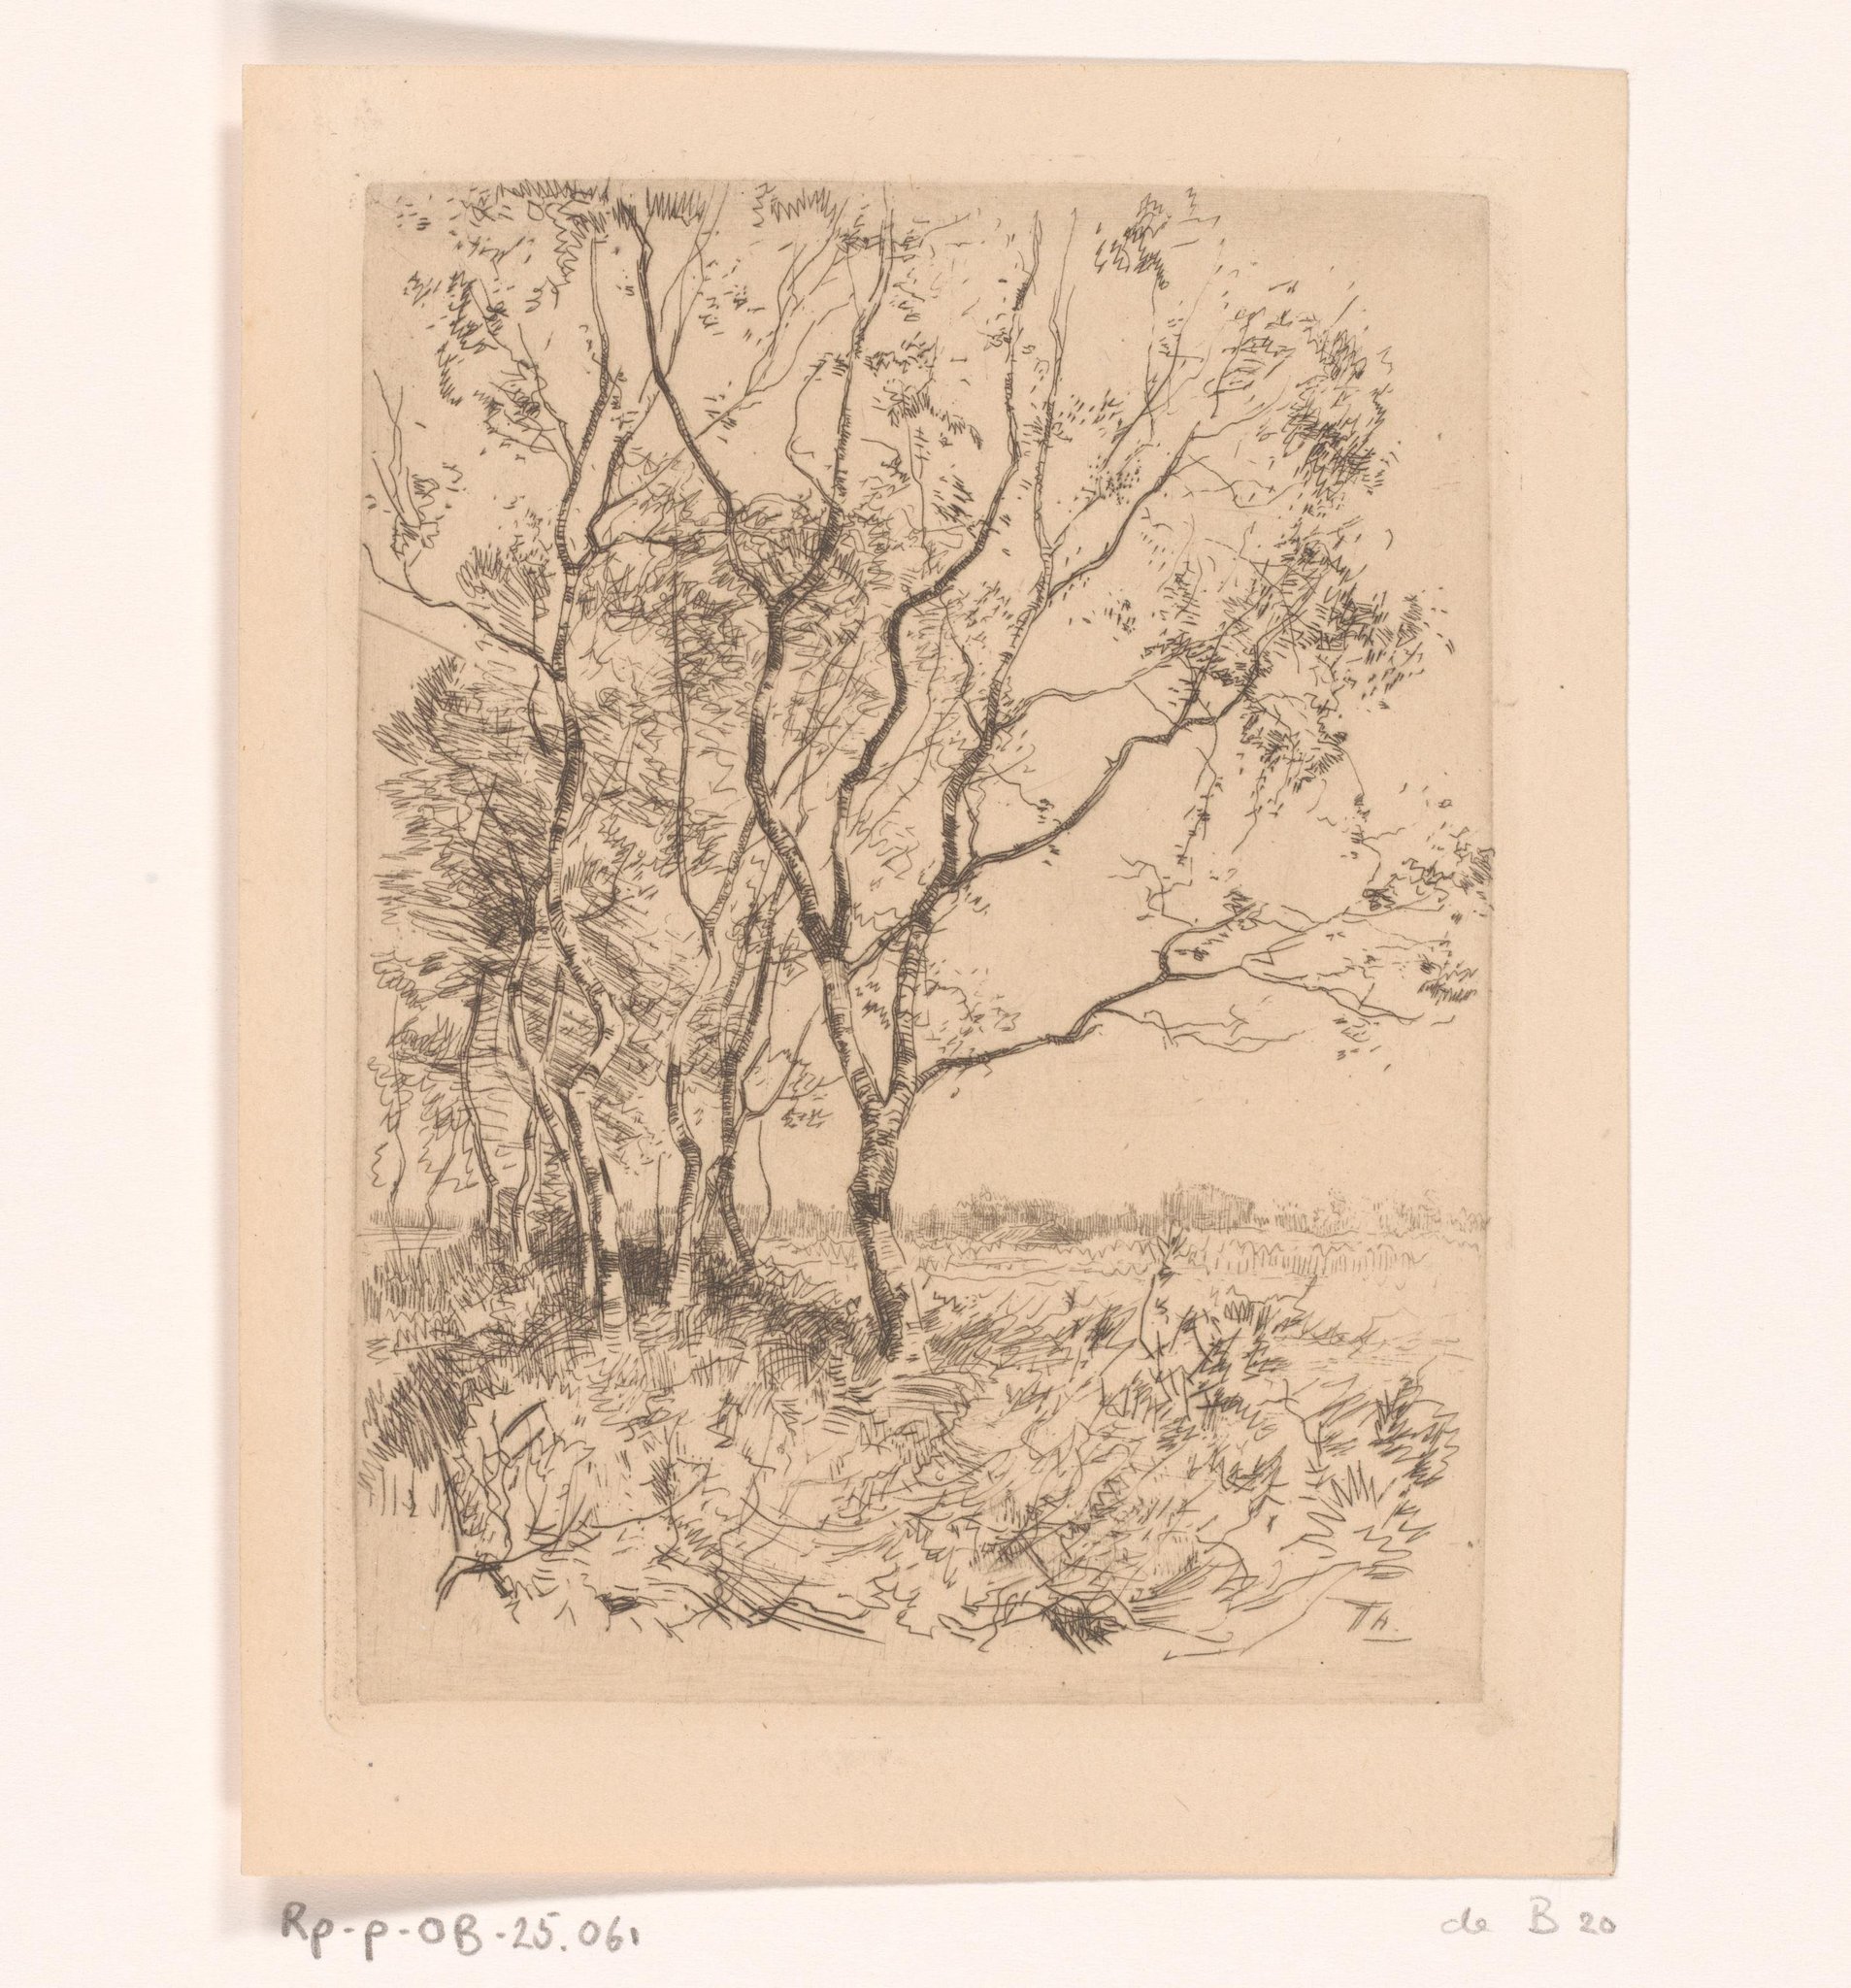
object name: print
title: Rij berken aan een weiland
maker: willem bastiaan tholen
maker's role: draughtsman, painter, print maker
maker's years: 1860-1931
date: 1888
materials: paper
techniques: etching, intaglio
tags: meadow, pasture, trees: birch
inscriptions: collector's mark: Lugt 2228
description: Prent verscheen in 1888 als onderdeel van de jaarlijkse uitgave van de 'Portefeuille der Nederlandsche Etsclub'.